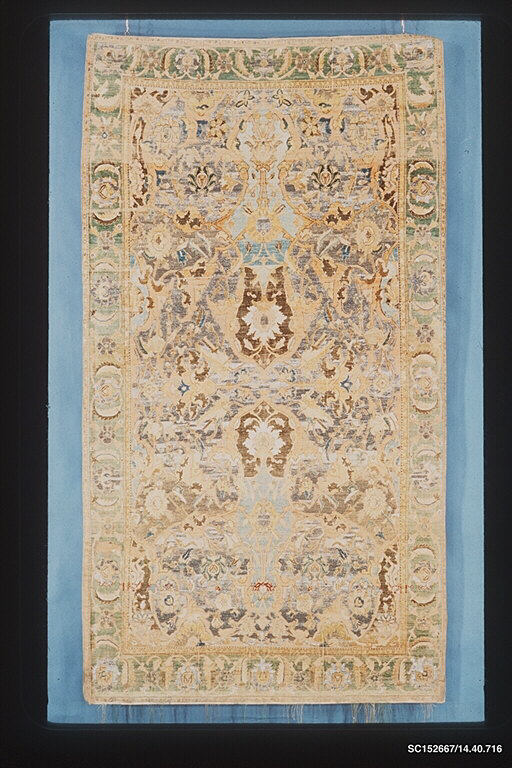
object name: carpet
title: Polonaise Carpet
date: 1601-1700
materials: metal thread, silk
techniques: asymmetrically knotted pile, brocade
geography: iran